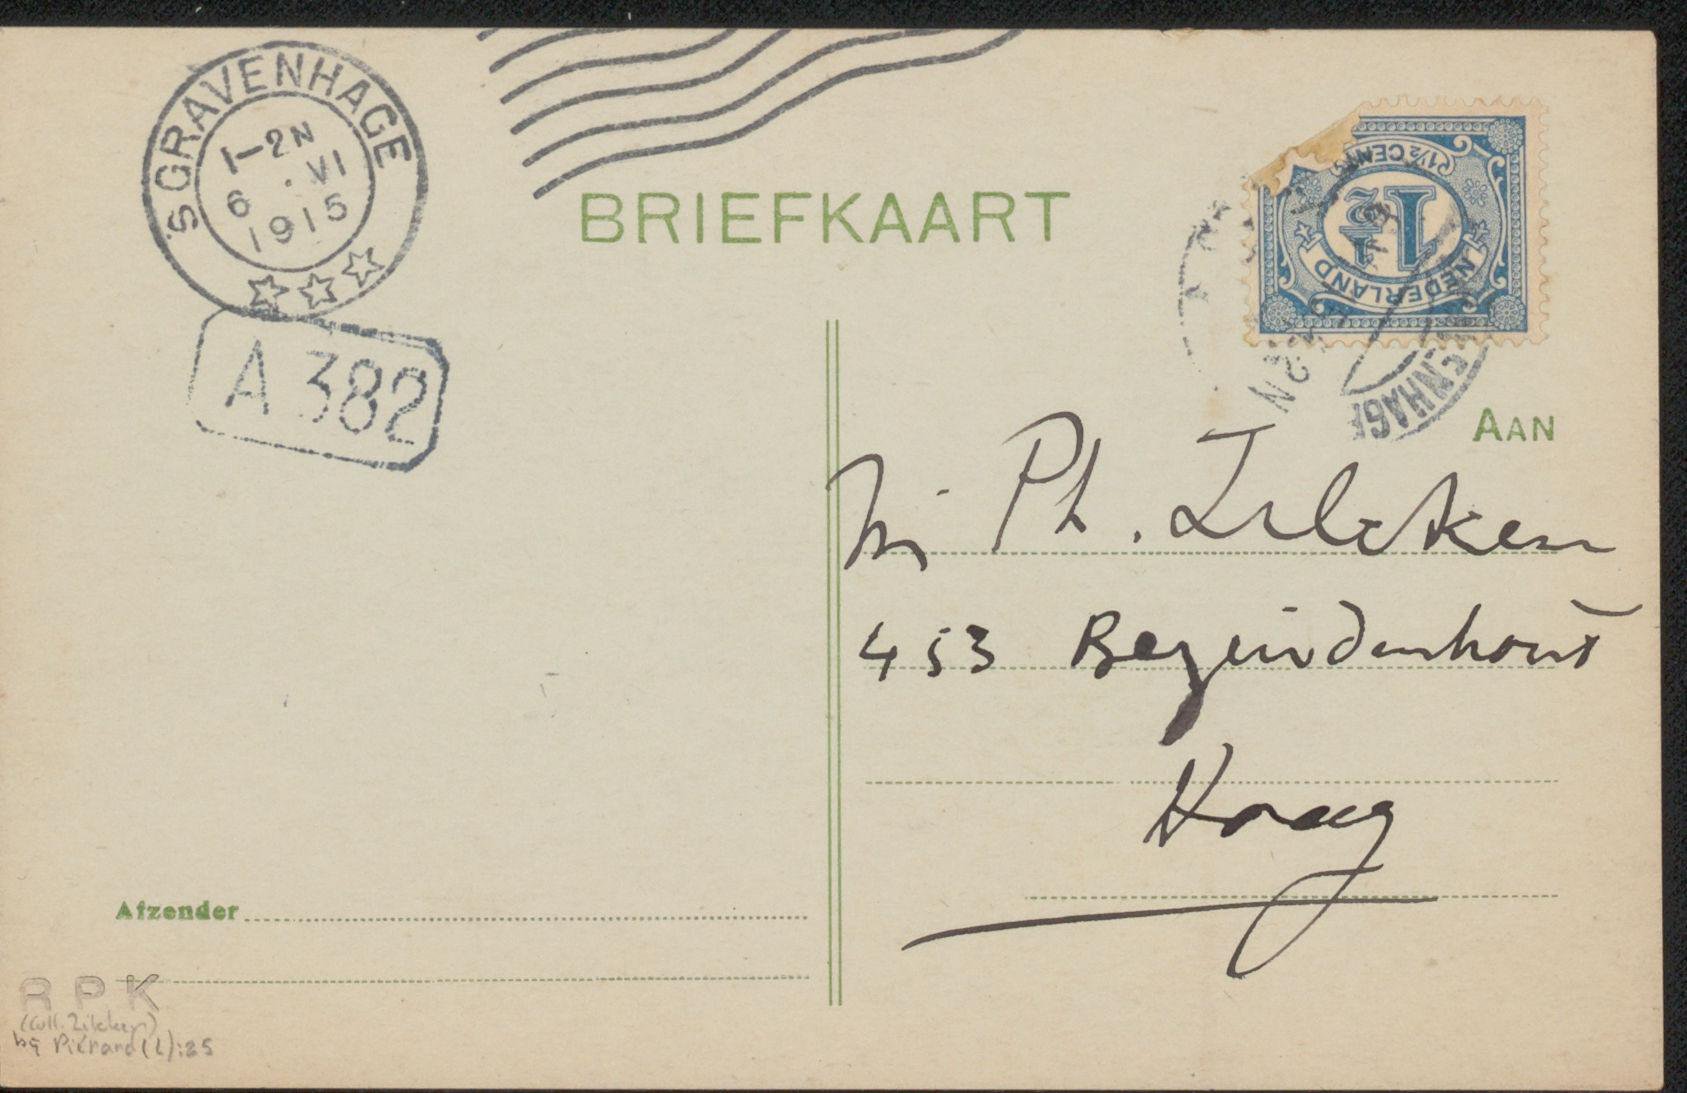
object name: postcard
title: Briefkaart aan Philip Zilcken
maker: louis piérard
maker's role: letterkundige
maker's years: 1886-1951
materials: cardboard, ink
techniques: pen, writing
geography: the hague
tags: print maker, hendrik willem mesdag, antwerp, franz melchers, the hague, painter, draughtsman, philip zilcken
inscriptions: collector's mark: ‘RPK’